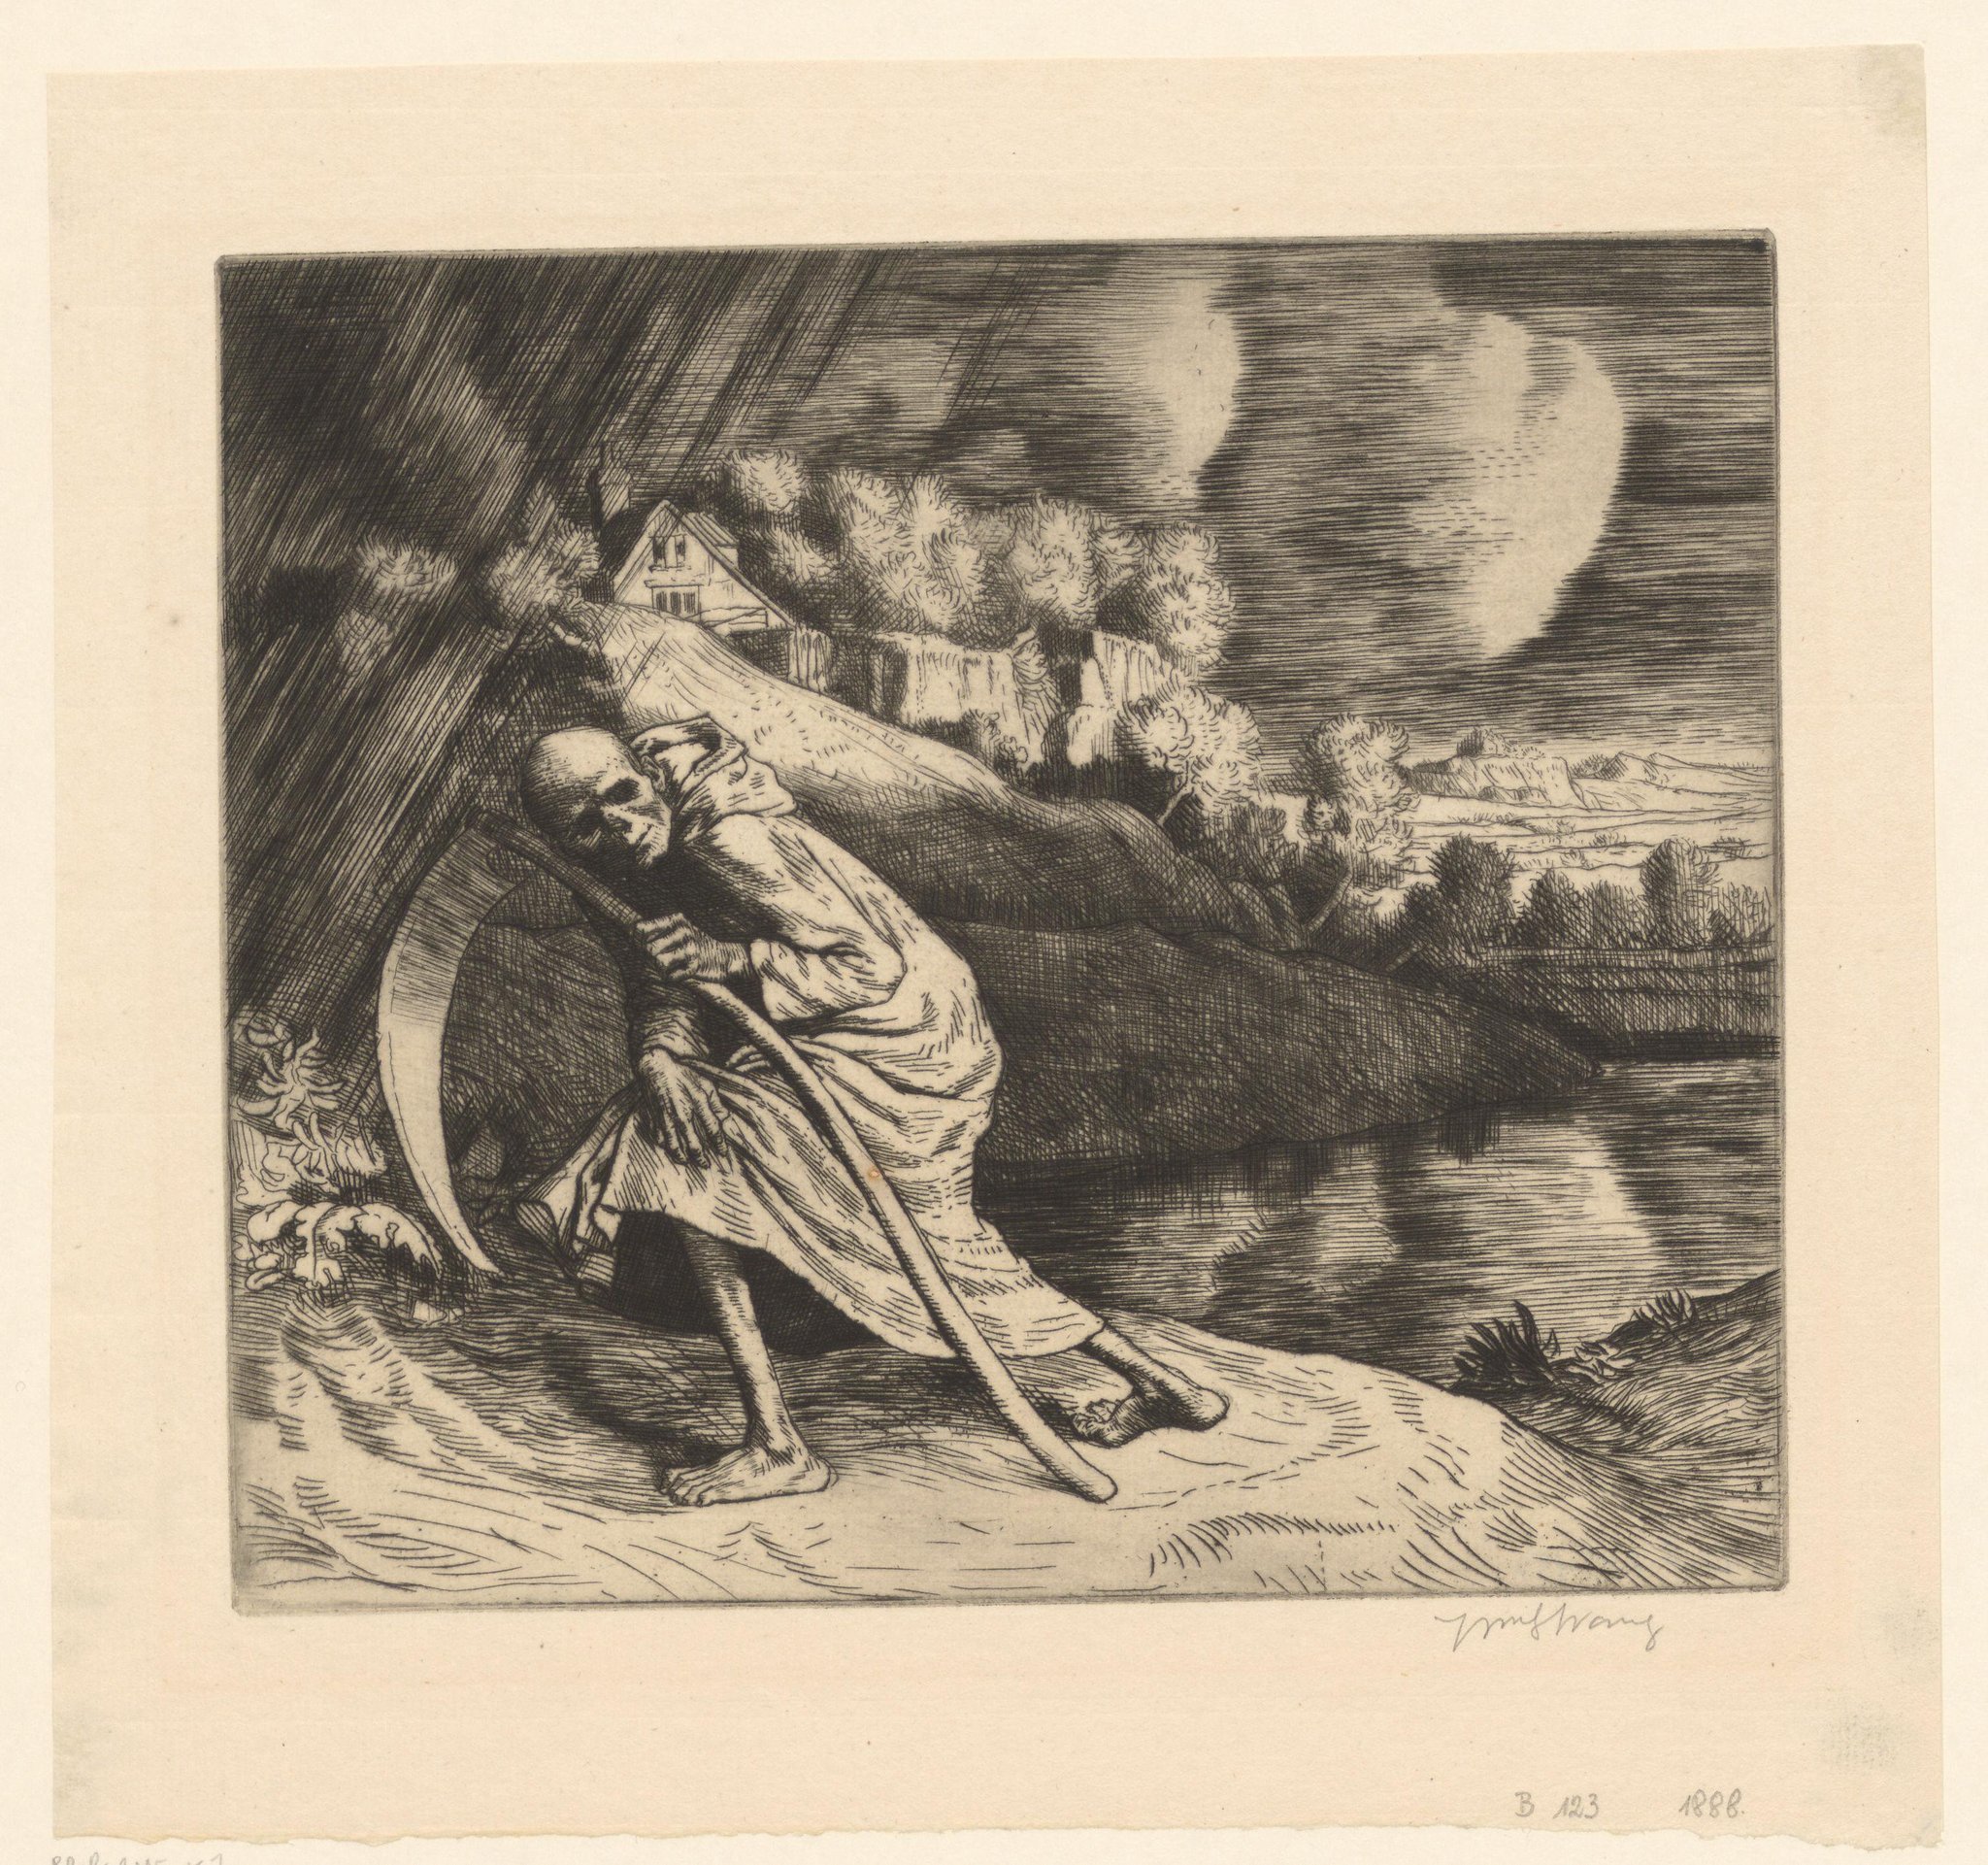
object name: print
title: Wi' Girning o'his Chaps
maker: william strang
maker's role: print maker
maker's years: 1859-1921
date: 1892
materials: paper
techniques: etching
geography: london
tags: death as old man, night ~ landscape (sometimes titled 'nox'), storm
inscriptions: signature: ‘WmStrang’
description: Op een landweg de Dood in een pij, schedel als hoofd, zeis in de linkerhand. Hij loopt bij nacht door een rivierlandschap in stormachtig weer.